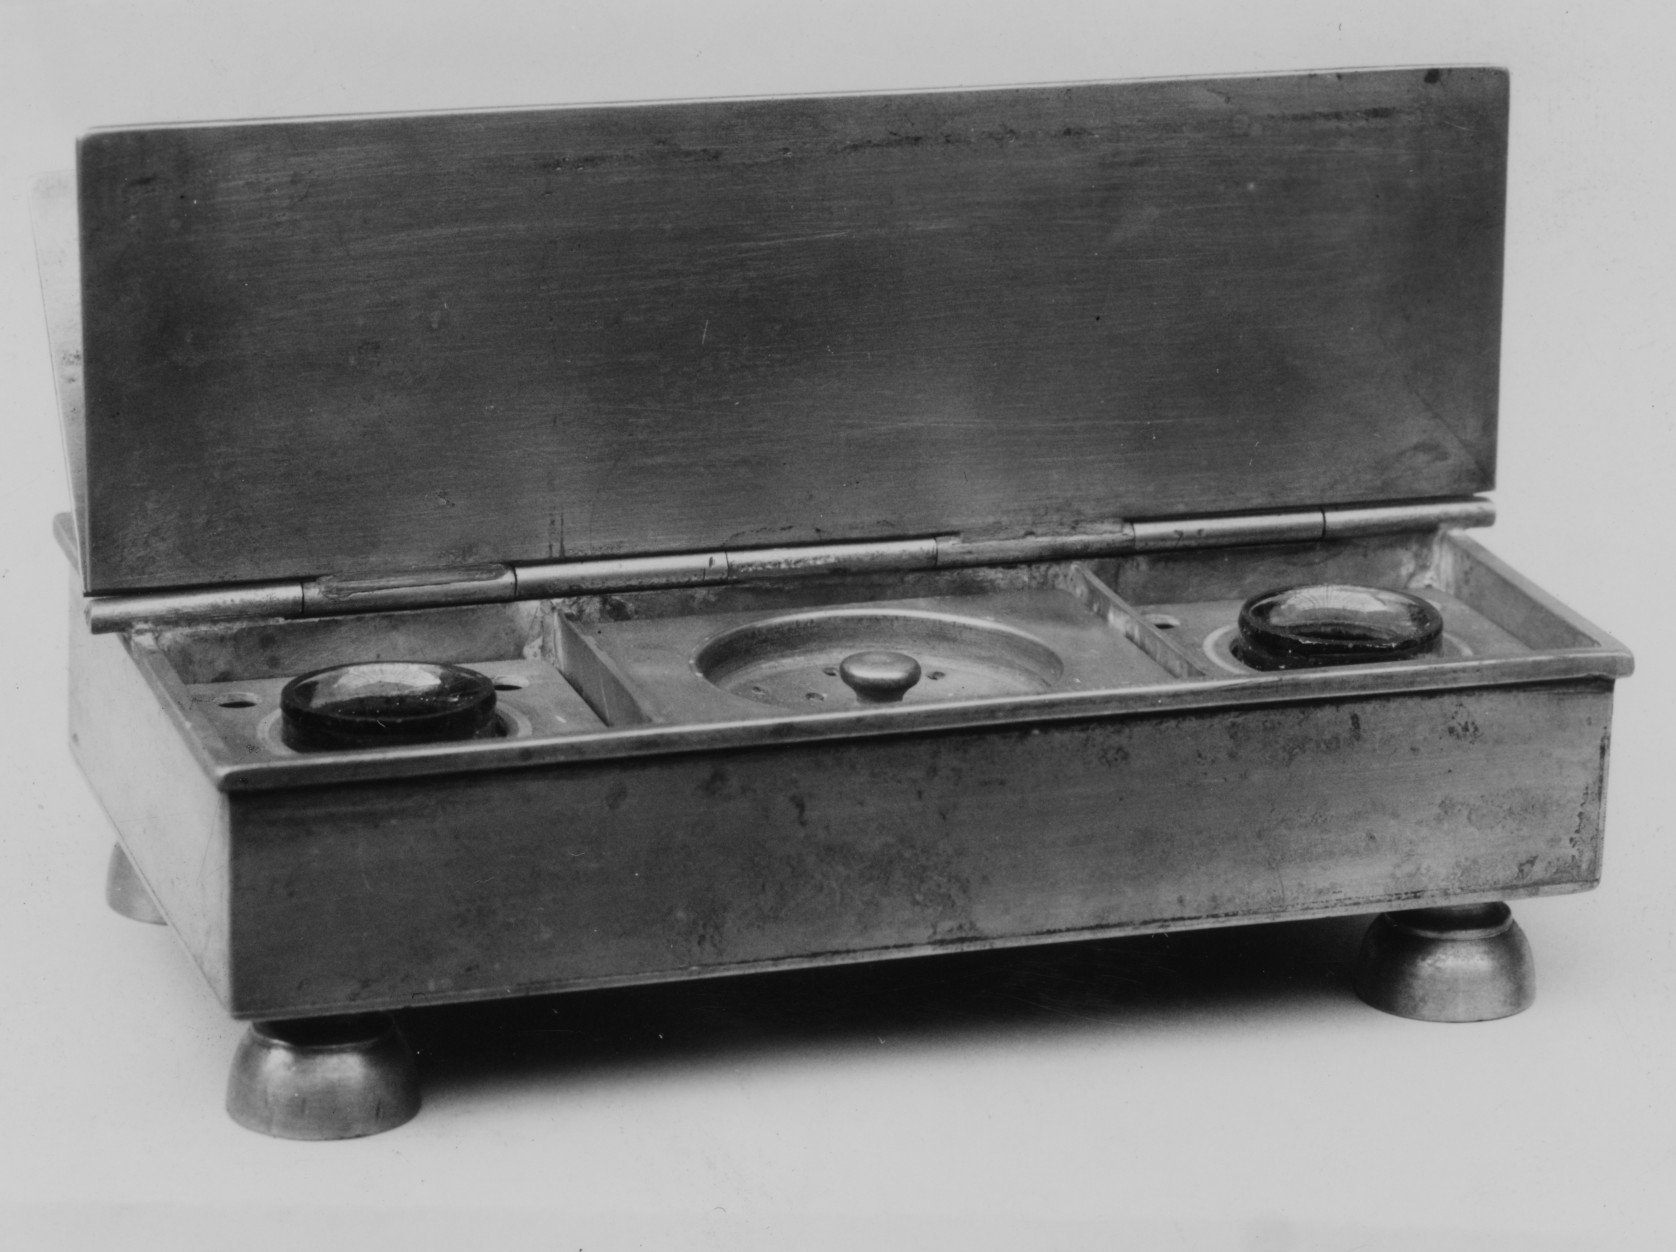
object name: inkstand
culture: american or british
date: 1700-1800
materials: pewter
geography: england